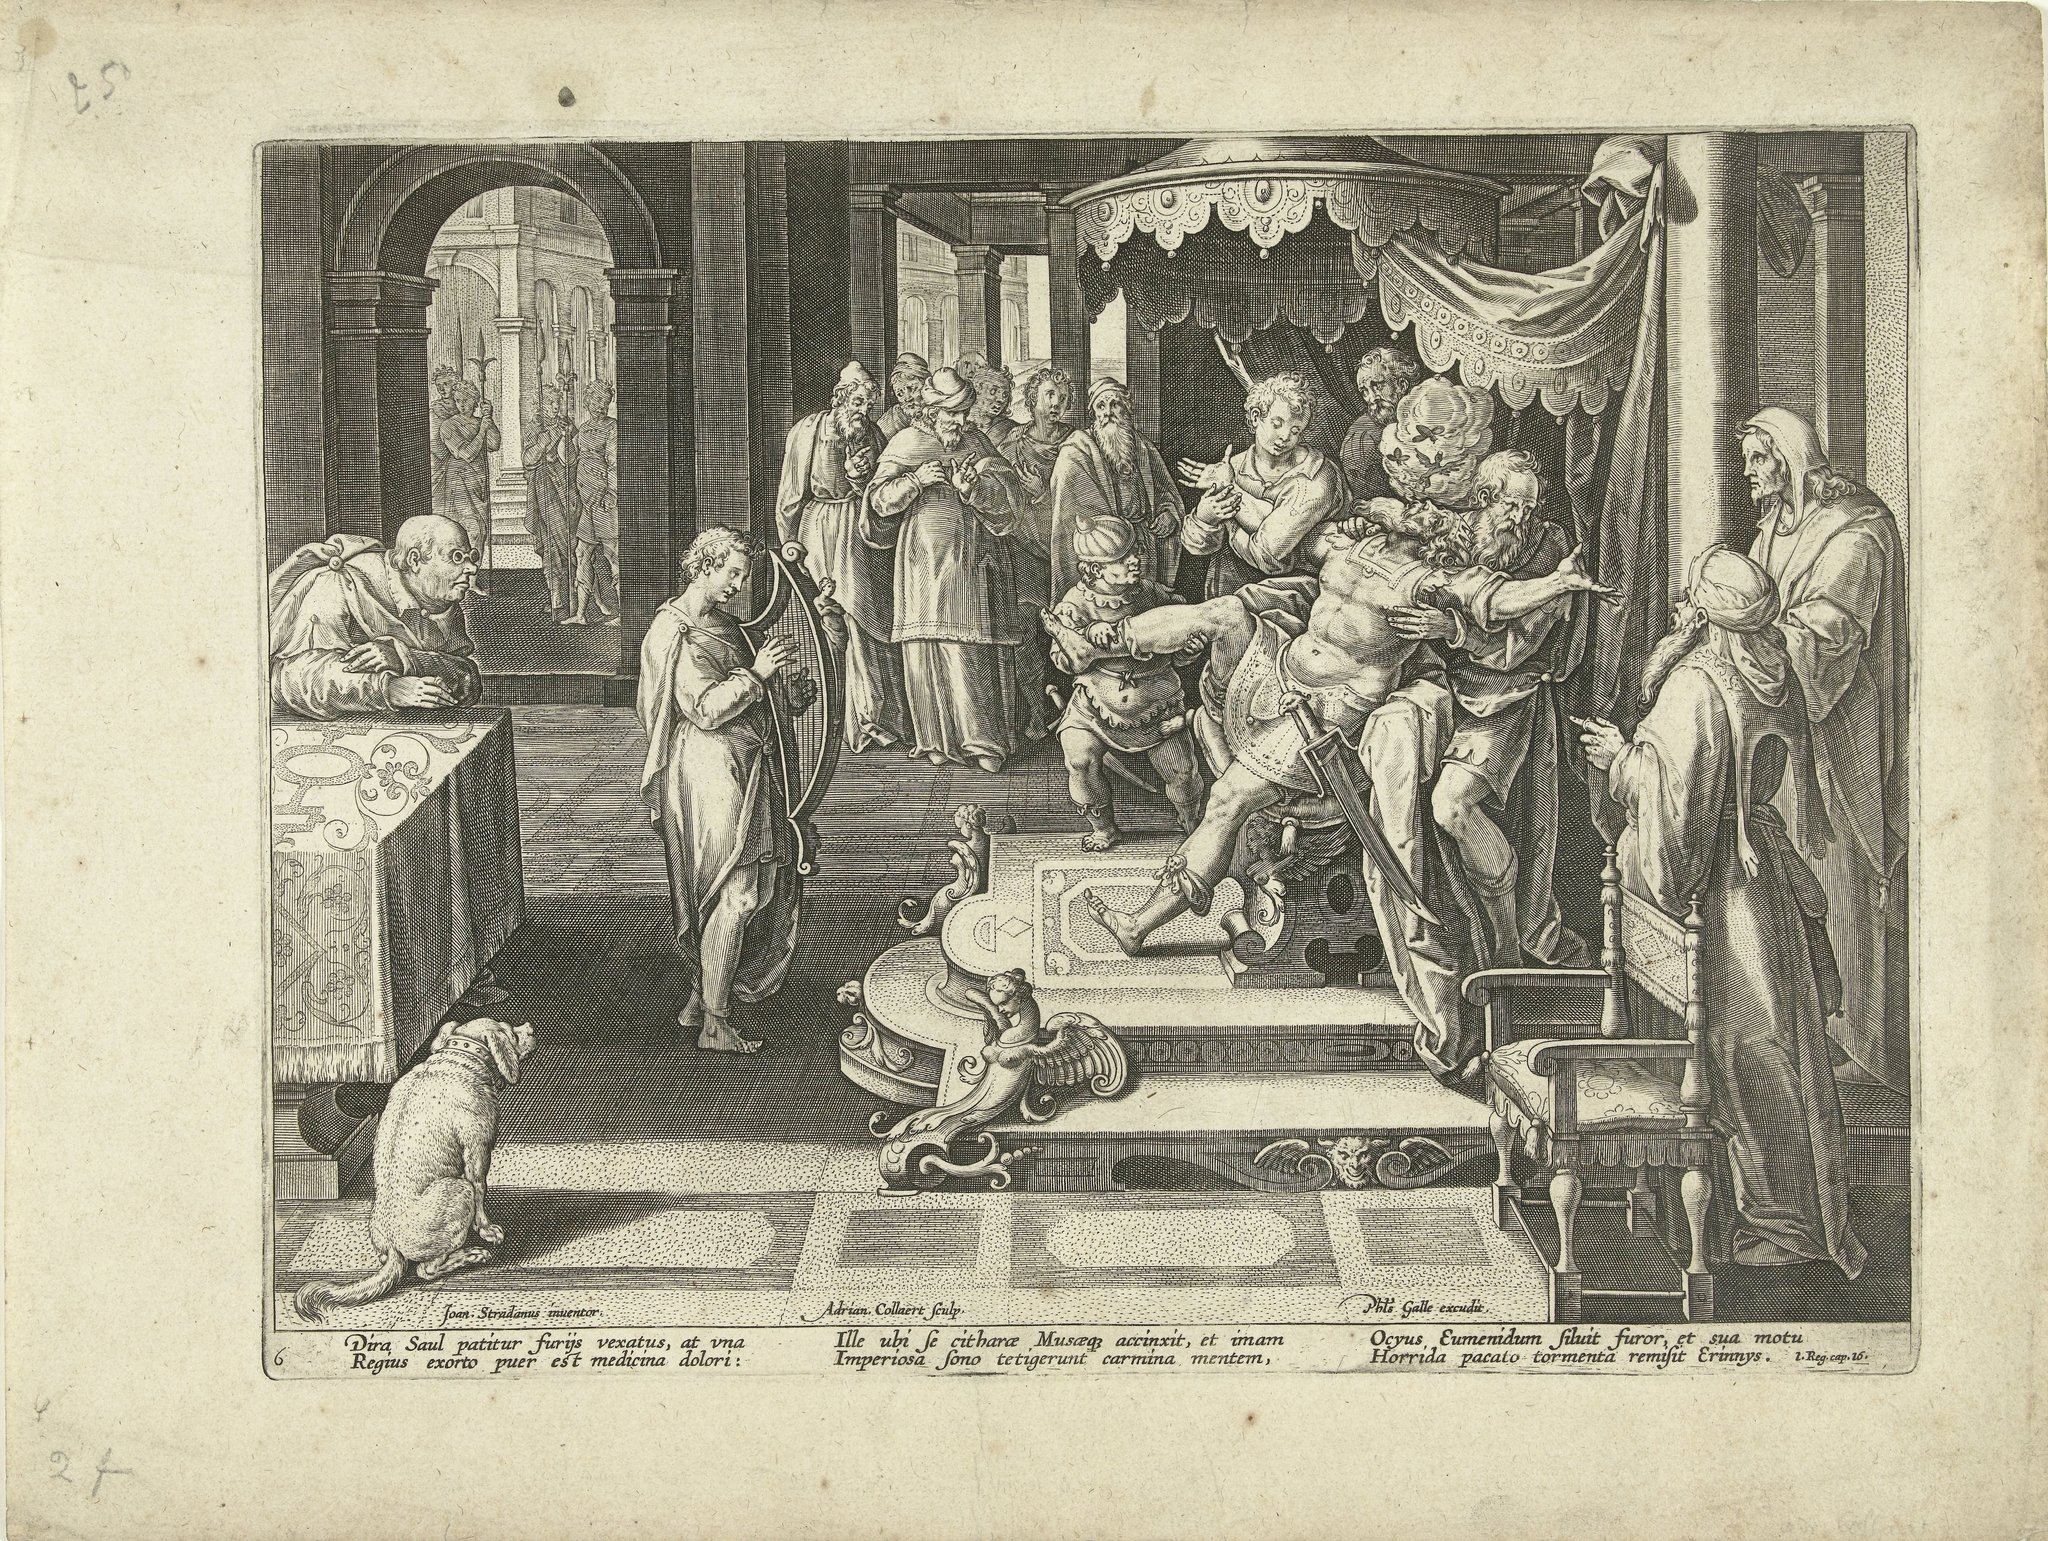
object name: print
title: David speelt op zijn harp voor Koning Saul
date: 1587-1591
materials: paper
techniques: engraving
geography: antwerp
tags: david playing his harp before saul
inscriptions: collector's mark: Lugt 2760, collector's mark: Lugt 2228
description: David speelt voor de troon van koning Saul. Het harpspel verjaagt de kwade geest die Saul kwelt. (1 Samuël 16:23) De prent heeft een Latijns onderschrift met verzen. De prent is deel van een serie met scènes uit het Oude Testament die te maken hebben met muziek.